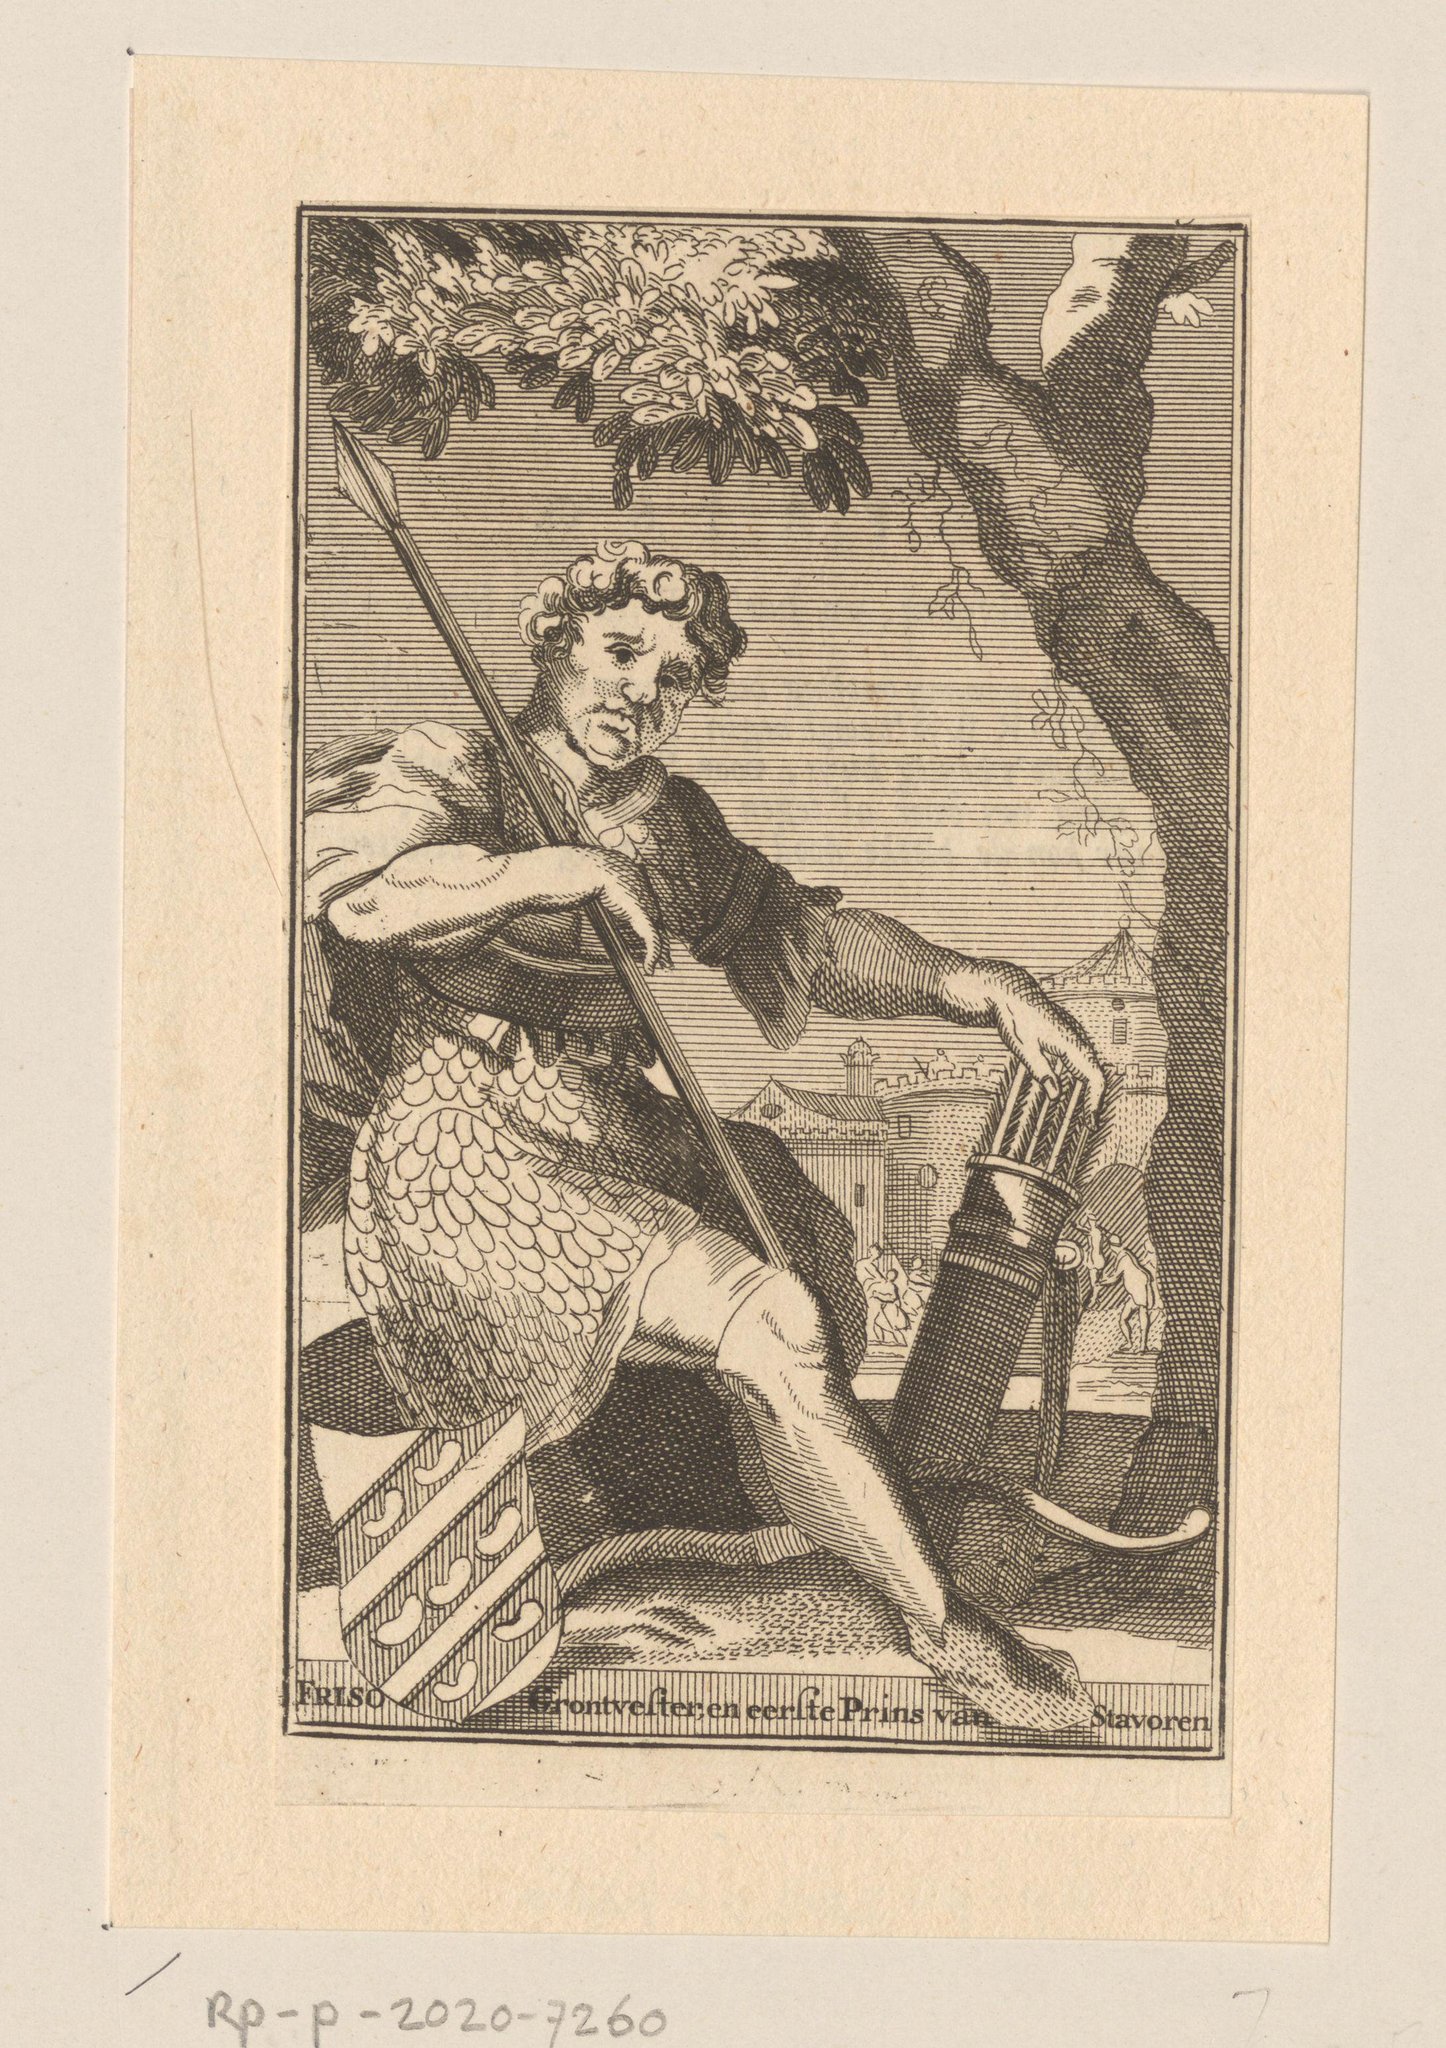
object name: print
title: Portret van Friso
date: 1702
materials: paper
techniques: etching, letterpress printing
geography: amsterdam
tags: archer's weapons: bow and arrow, prince, historical persons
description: Prent uit: Soeteboom, Hendrik Jacobsz. Oud-heden van Zaan-land, Stavoren, Vronen en Waterland (...). Amsterdam: Wilhem Linnig van Koppenol, 1702, dl. 2.